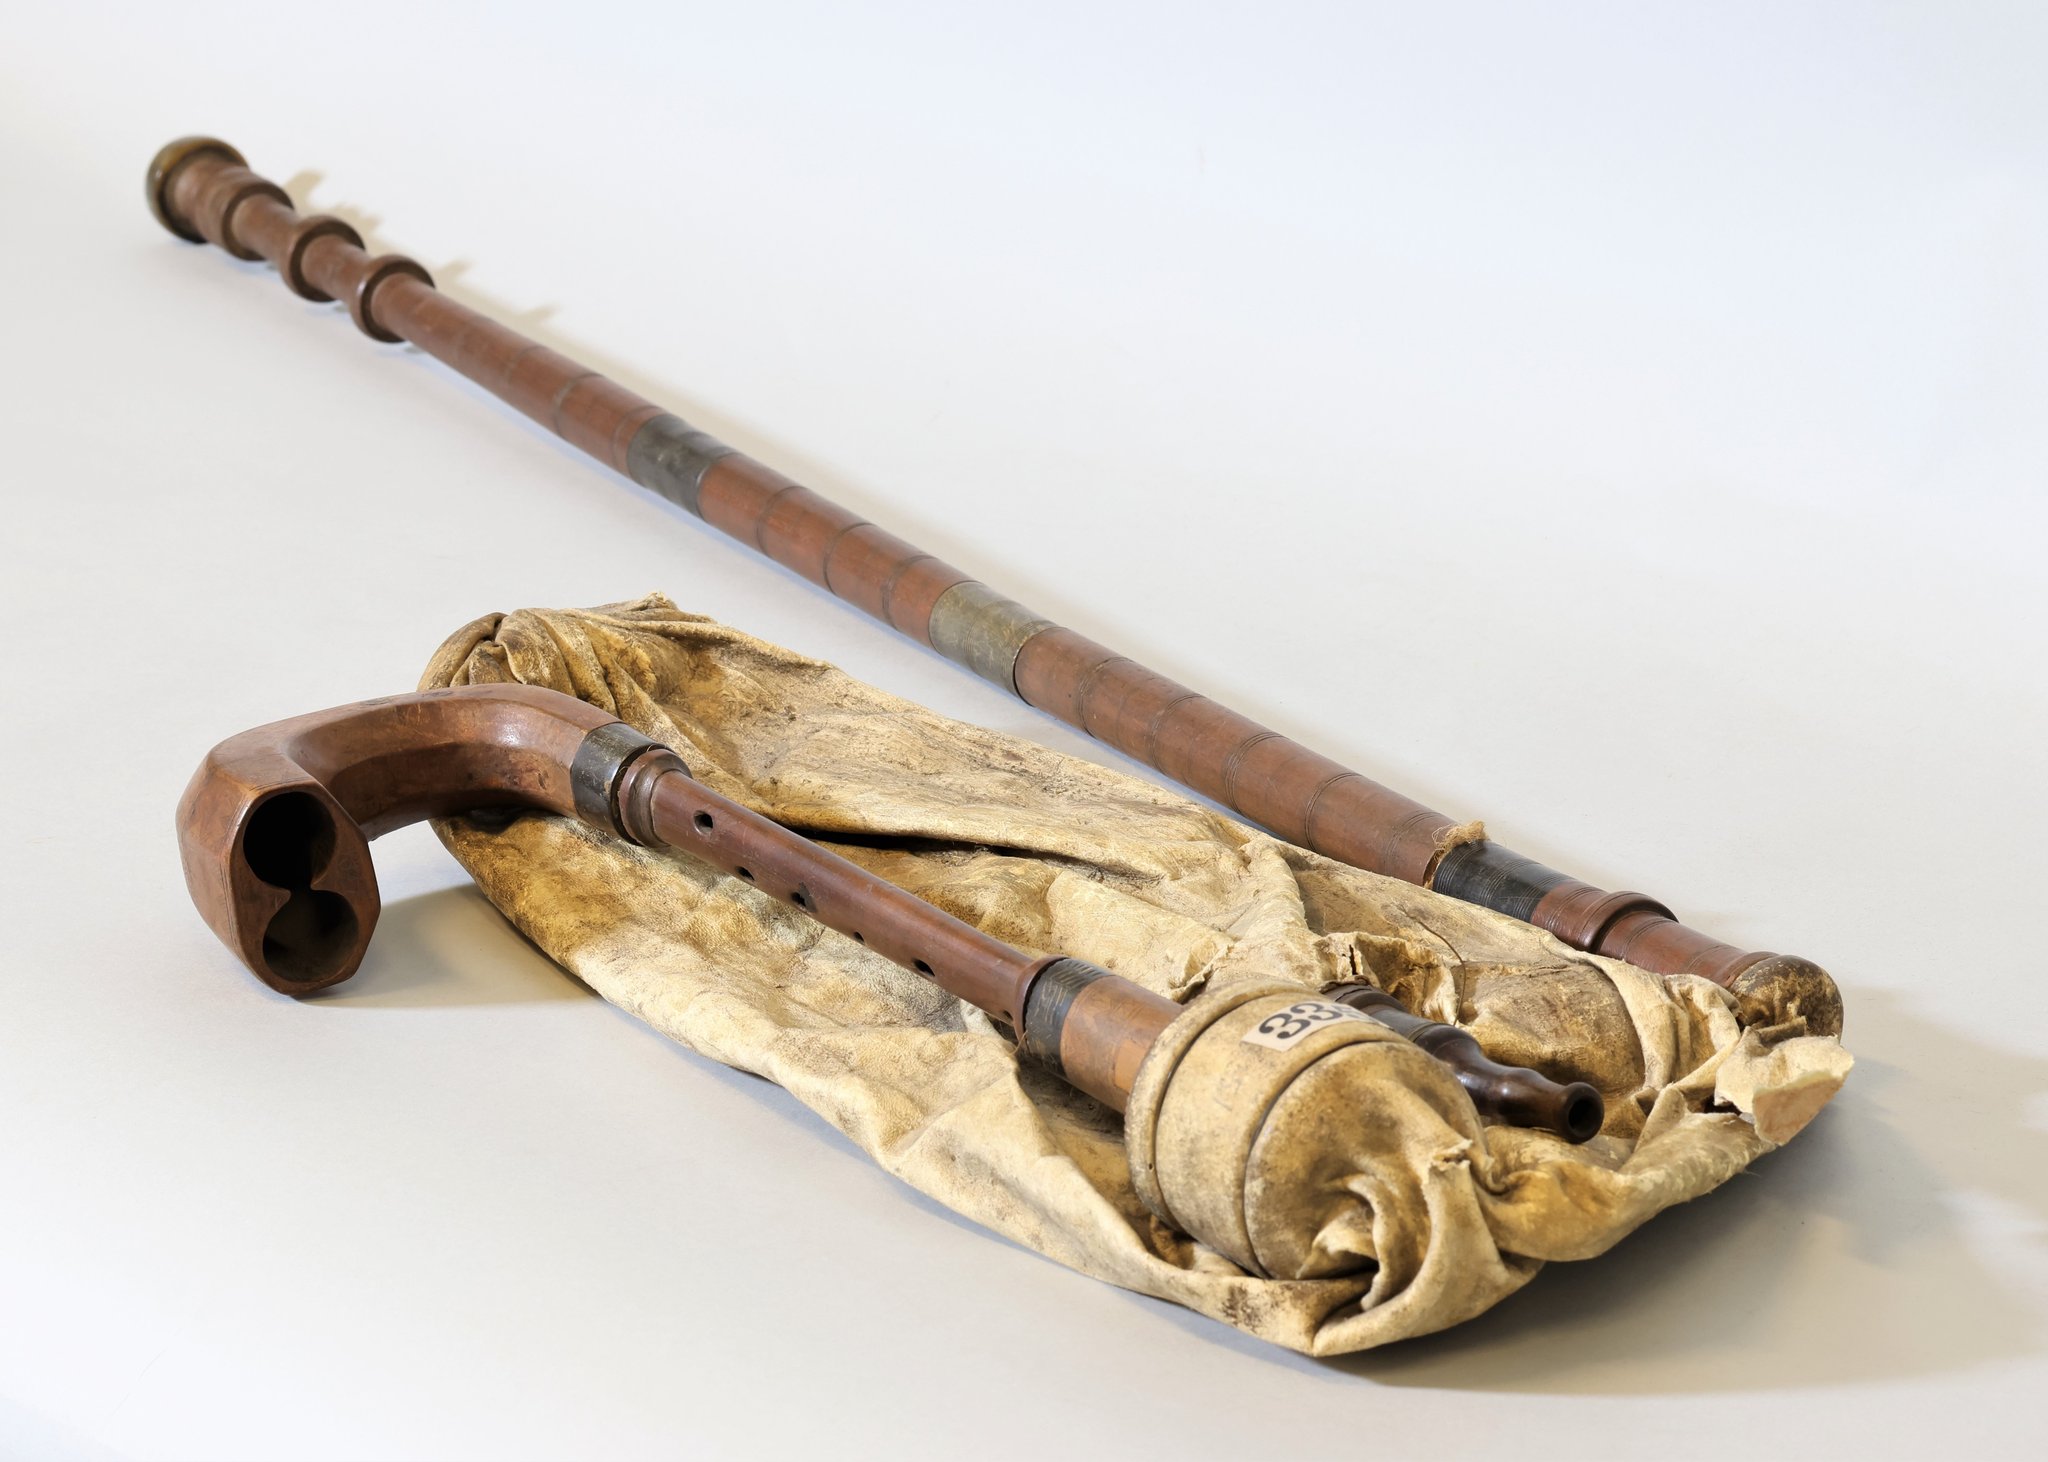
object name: gajde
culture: hungarian or slavonian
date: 1867-1900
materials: brass, leather, horn, wood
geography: serbia